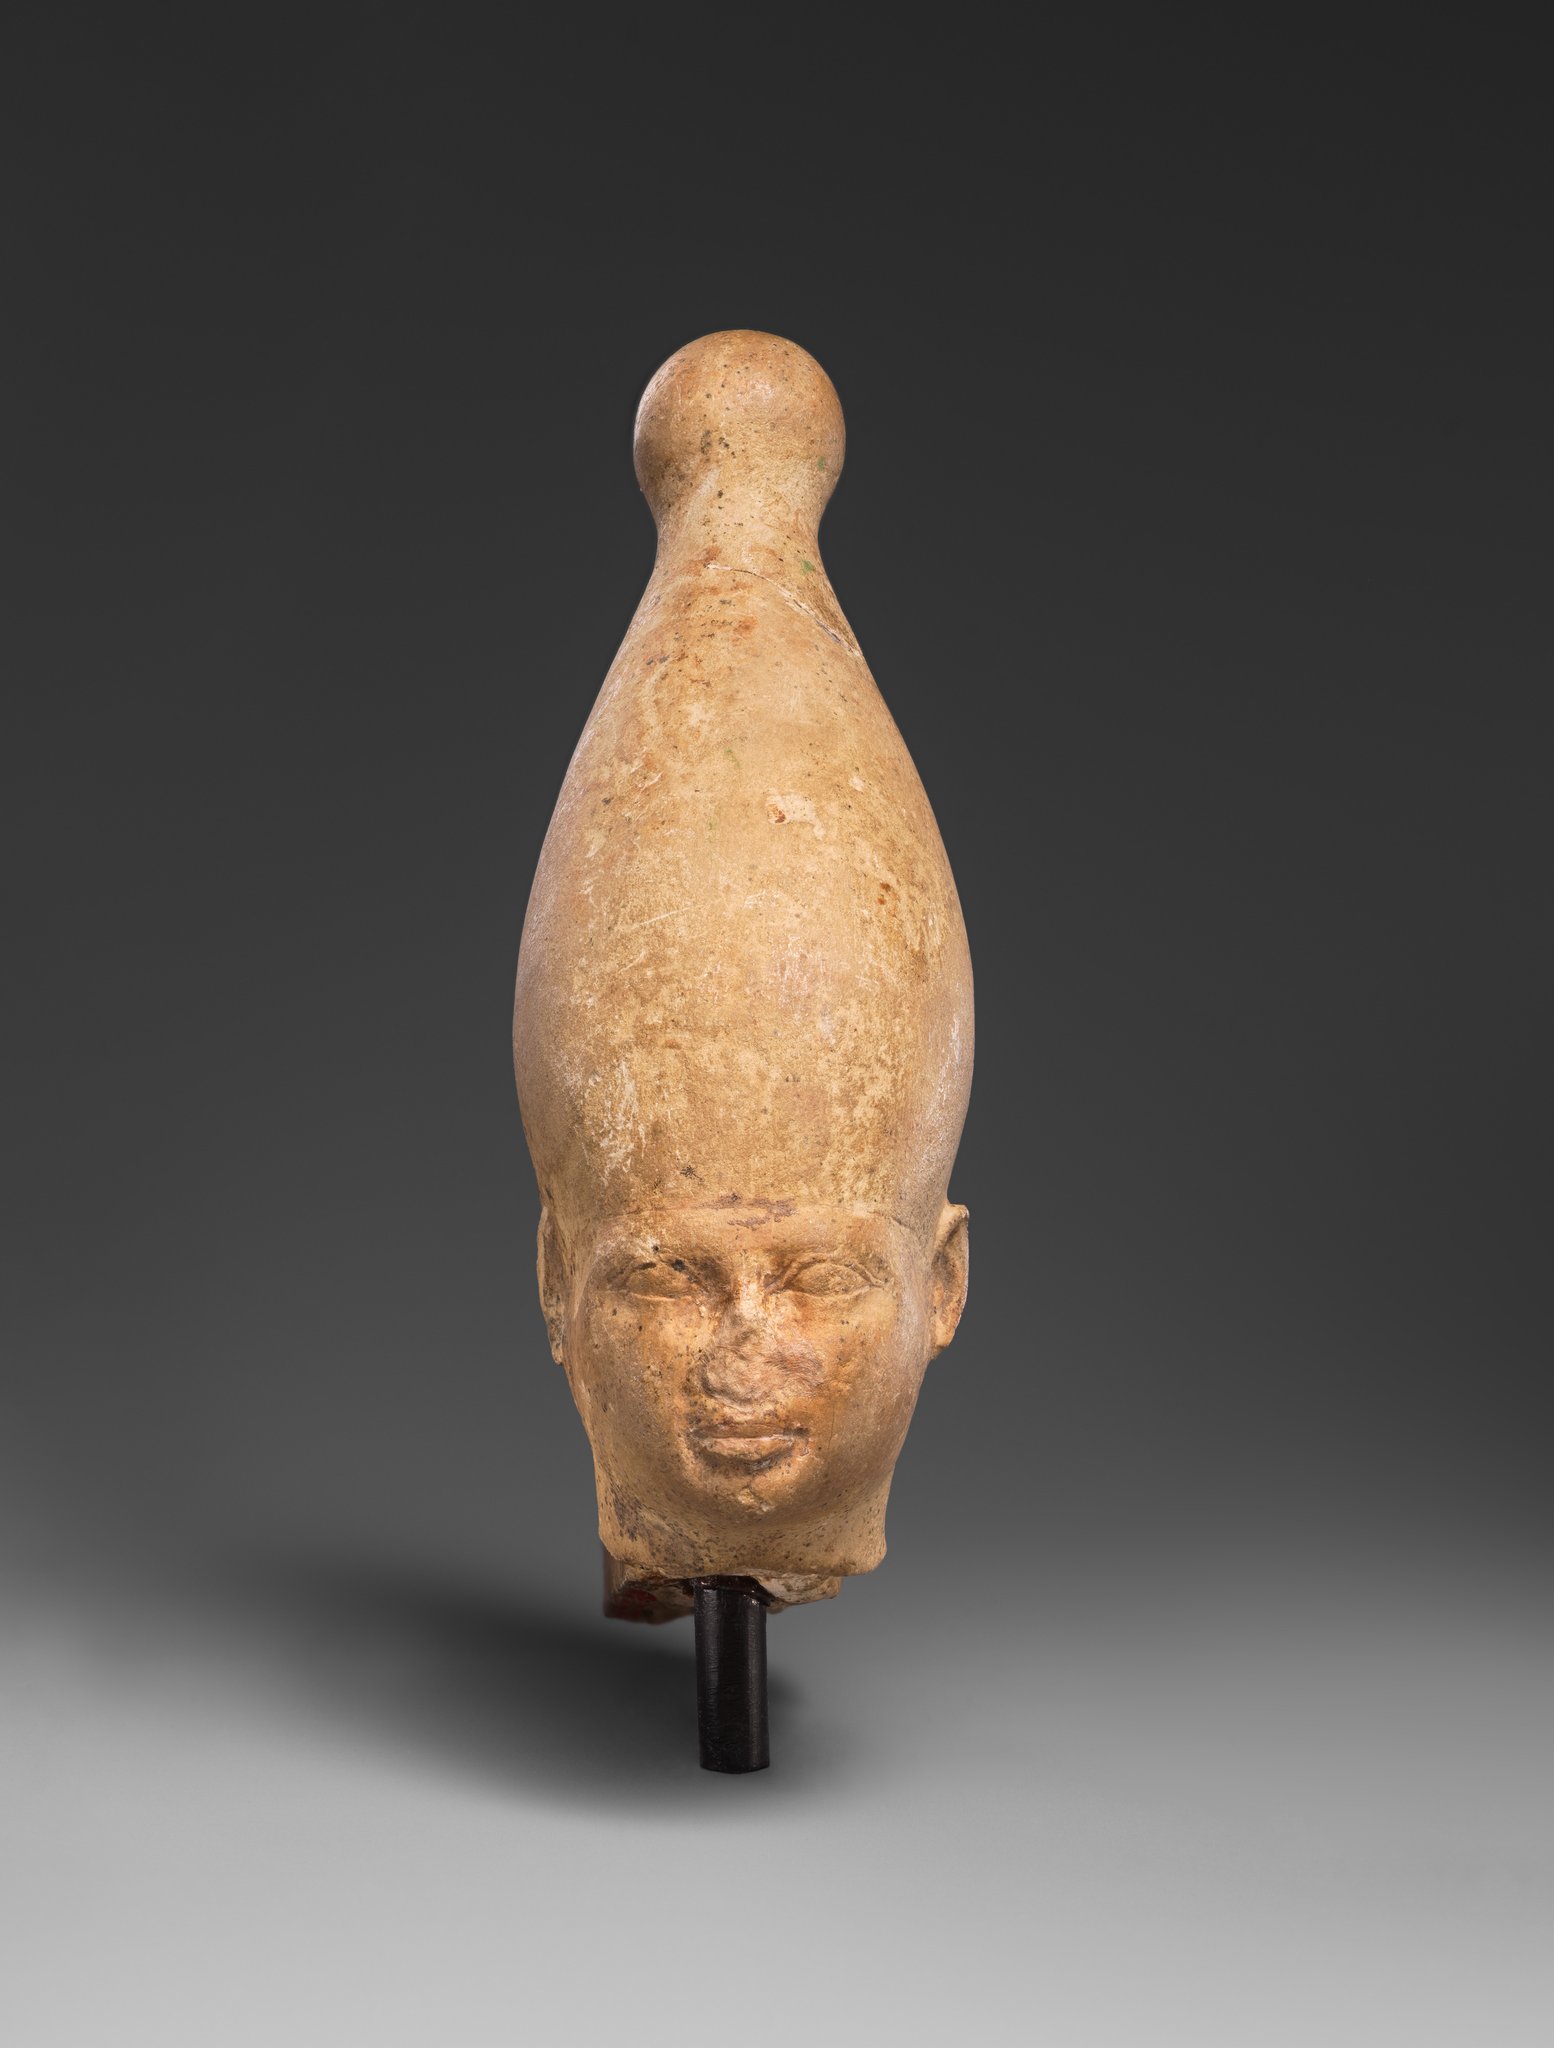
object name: head of a fourth dynasty king in a white corwn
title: Head of a Fourth Dynasty King in a White Crown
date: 2575-2465 BCE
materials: limestone, paint